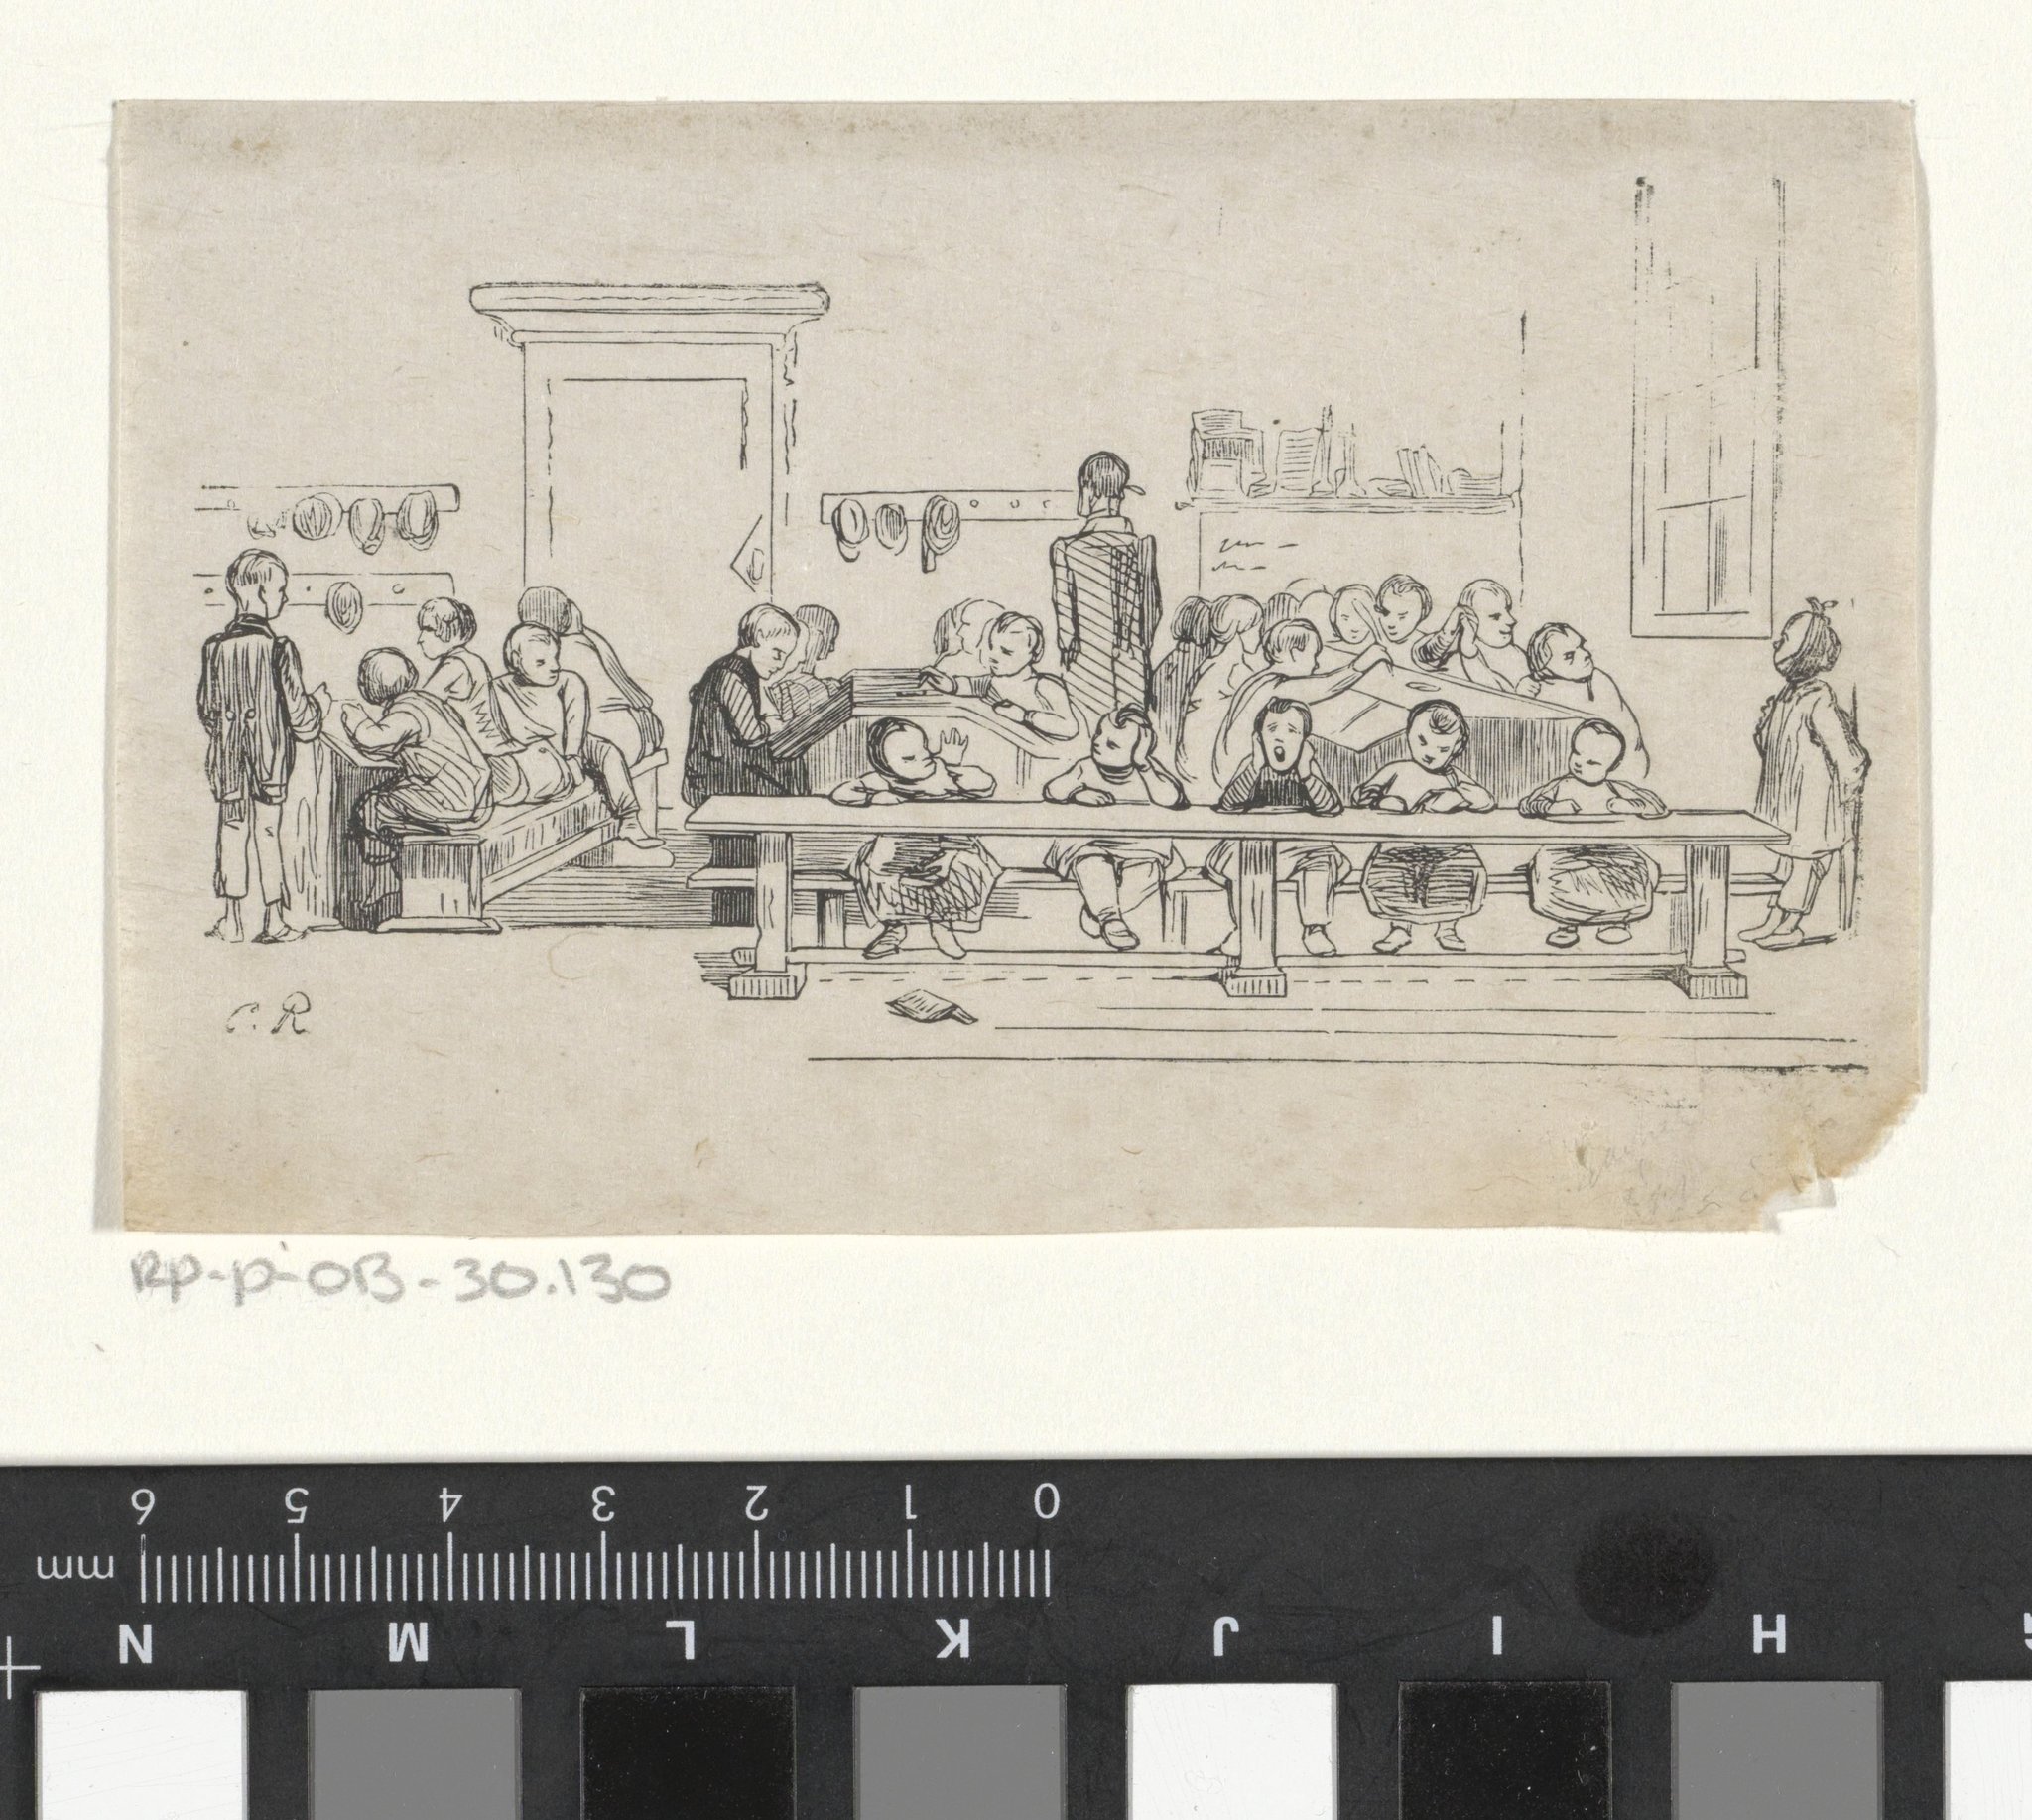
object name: print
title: Schoolklas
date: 1836-1873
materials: paper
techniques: engraving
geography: the hague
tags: teacher and pupil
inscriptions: collector's mark: Lugt 2228